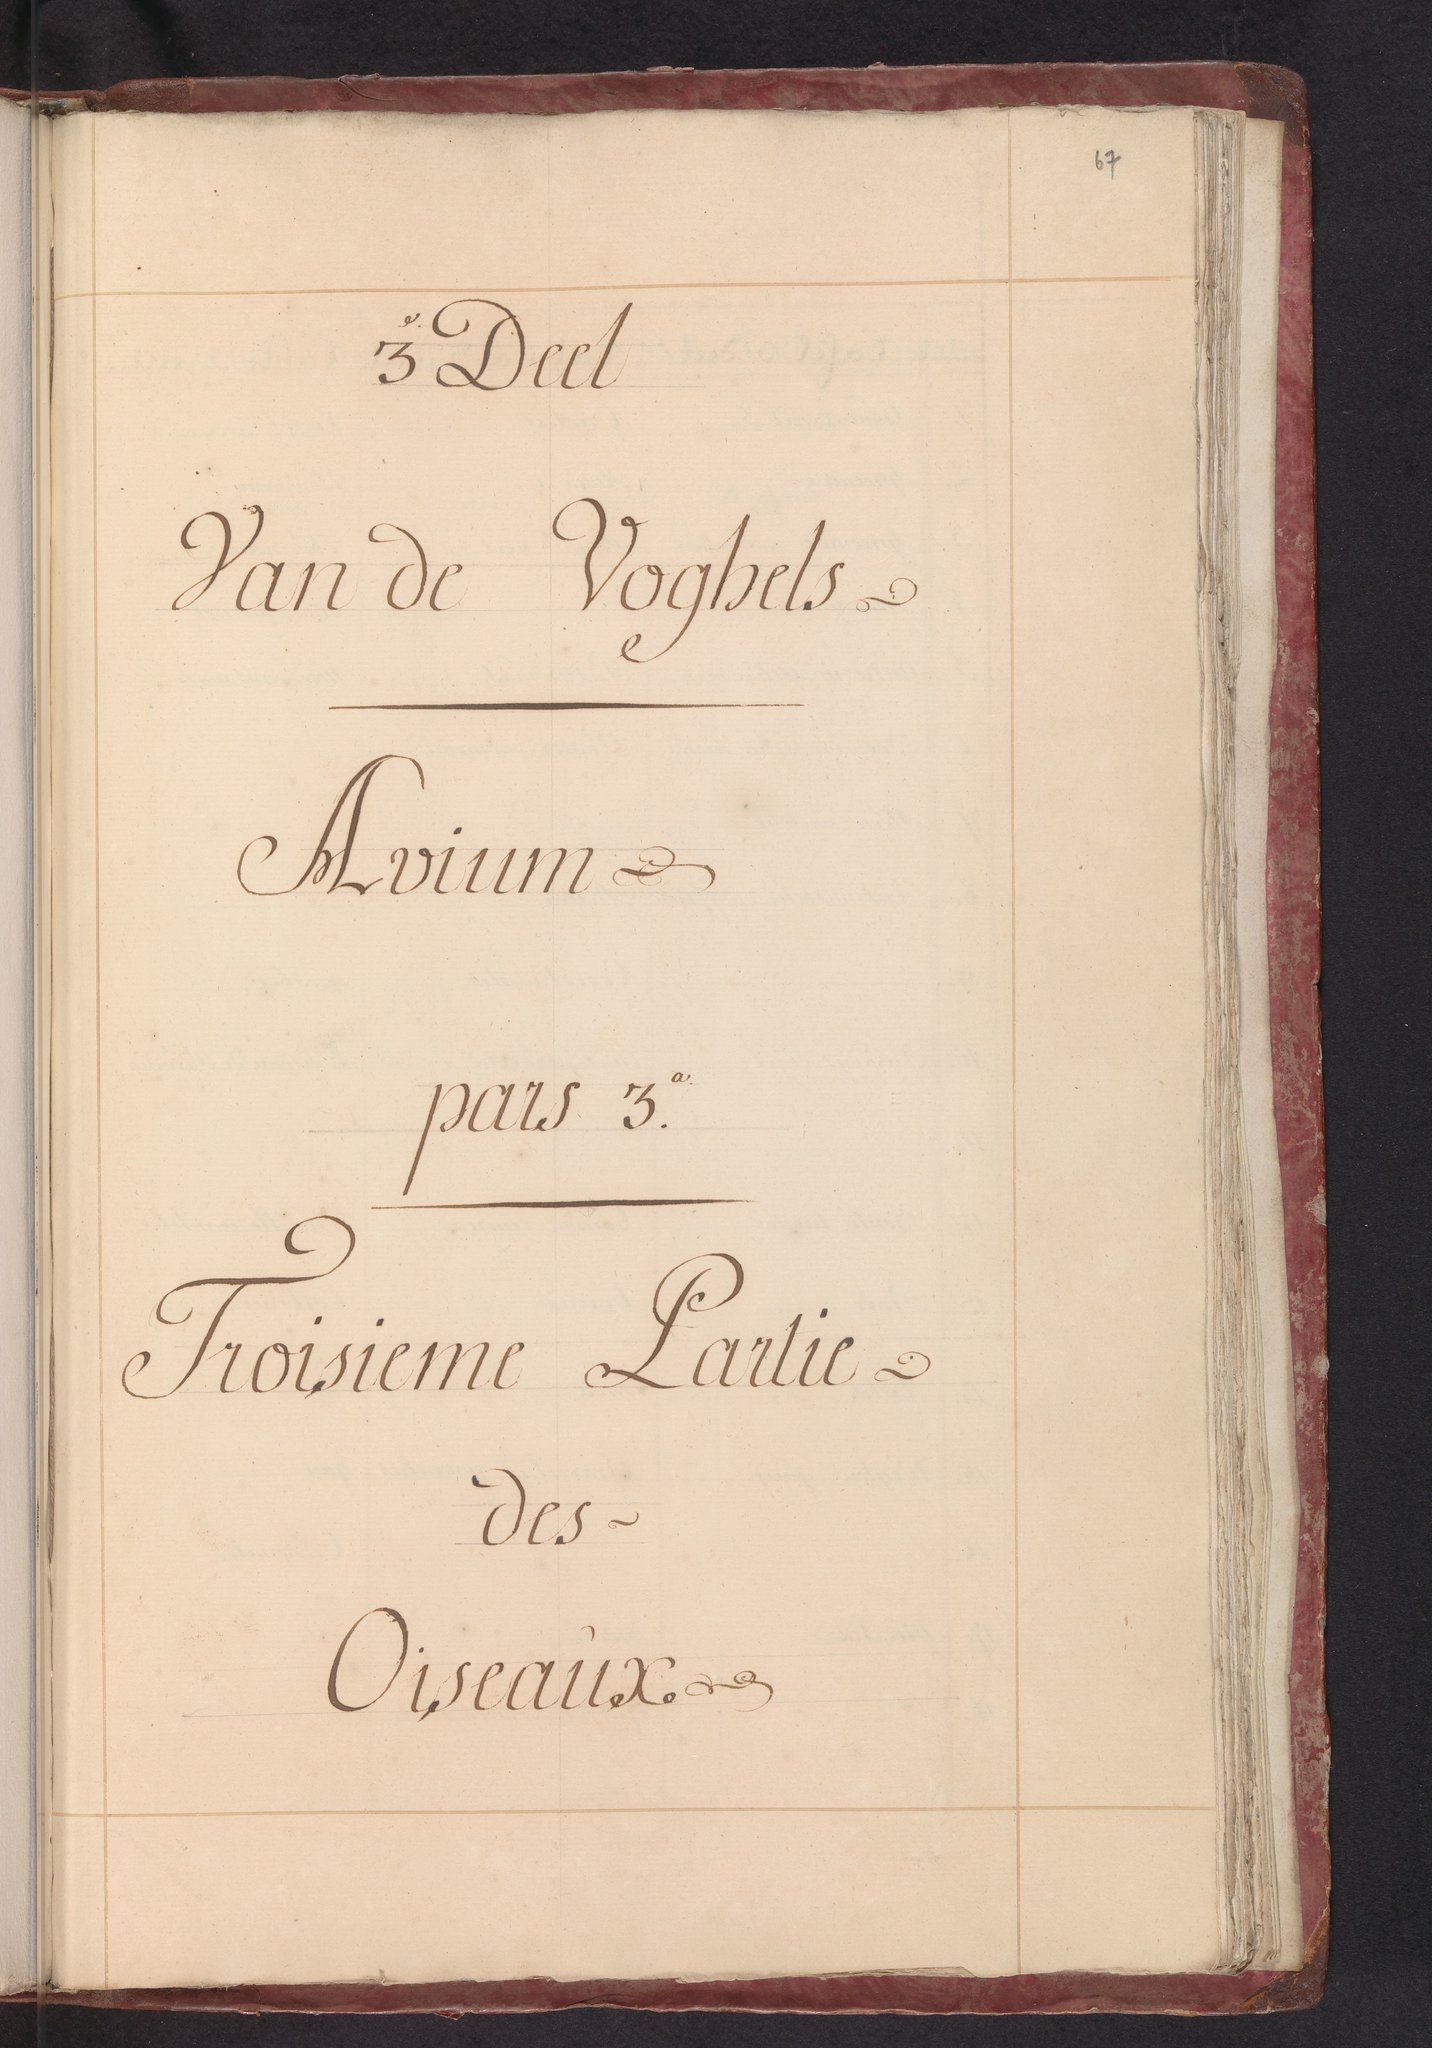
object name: manuscript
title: Titelpagina voor het derde deel van de vogels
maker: joseph van huerne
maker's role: kunstliefhebber, mecenas, verzamelaar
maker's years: 1752-1844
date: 1809-1814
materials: ink, paper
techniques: handwriting, pen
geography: bruges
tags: handwriting, written text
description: Handgeschreven titelpagina voor het derde deel van de voorstellingen van vogels. Onderdeel van het eerste album met tekeningen van vogels. Derde van twaalf albums met tekeningen van dieren, vogels en planten bekend rond 1600, gemaakt in opdracht van keizer Rudolf II. Met toelichting in Nederlands, Latijn en Frans.